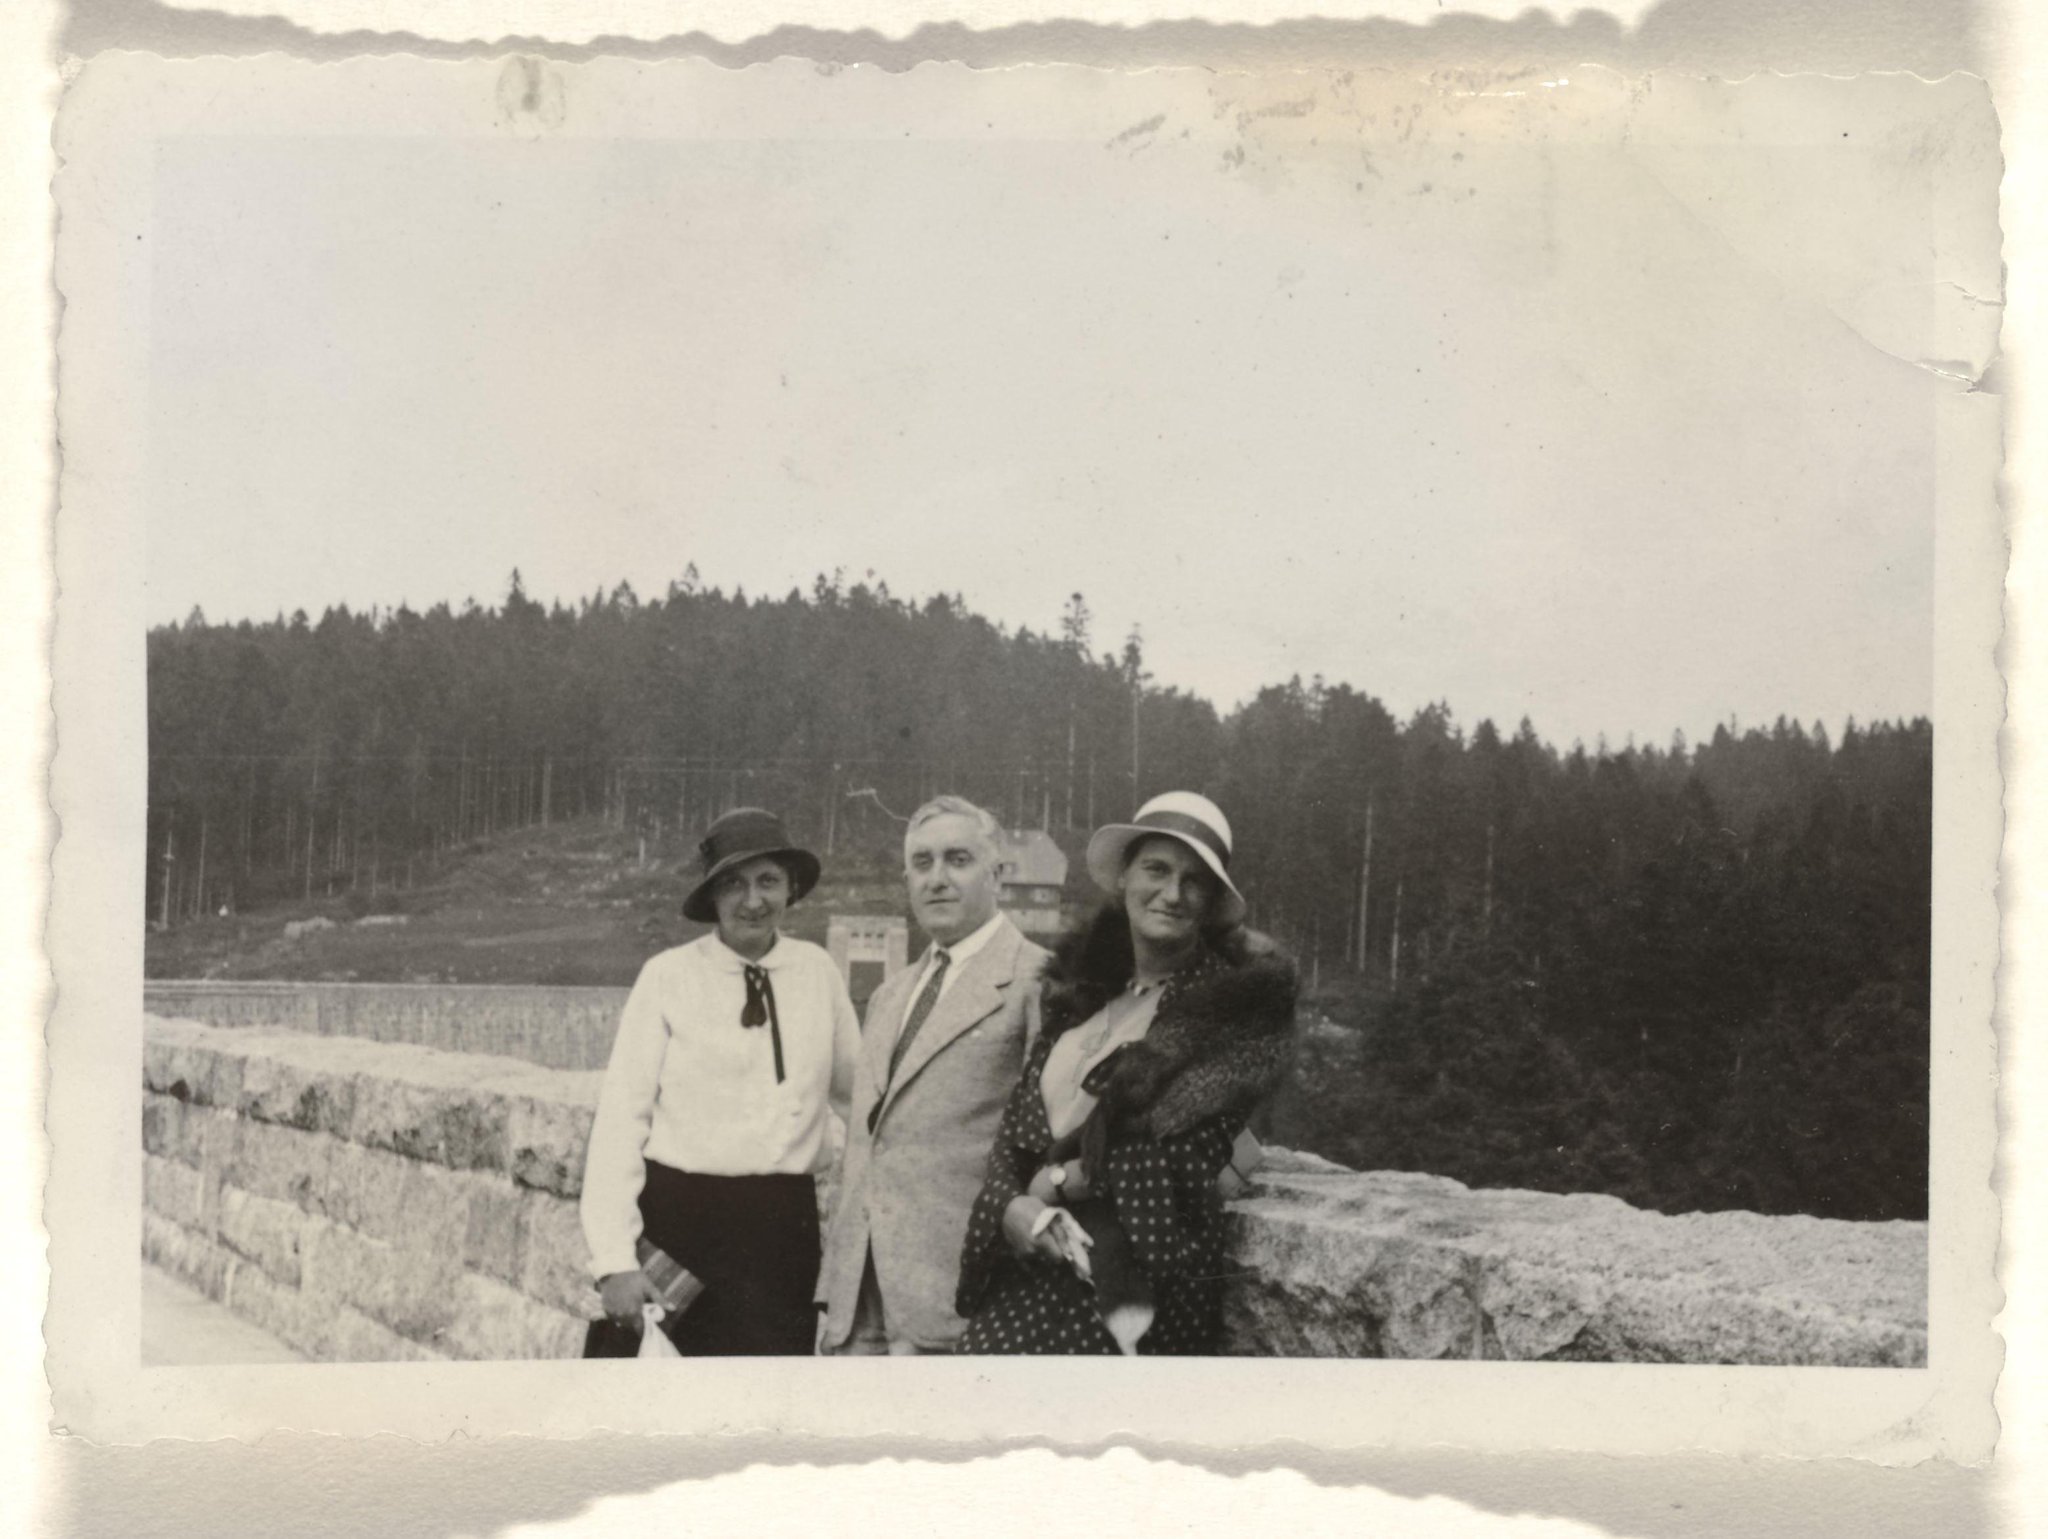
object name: photograph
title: Eugen Wachenheimer met twee onbekende vrouwen bij een stenen muur voor een bos in Baden-Baden, augustus 1932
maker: Anonymous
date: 1908-1932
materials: photographic support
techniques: gelatin silver print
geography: baden-baden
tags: eugen wachenheimer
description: Eugen Wachenheimer (midden) met twee onbekende vrouwen bij een stenen muur voor een bos in Baden-Baden.